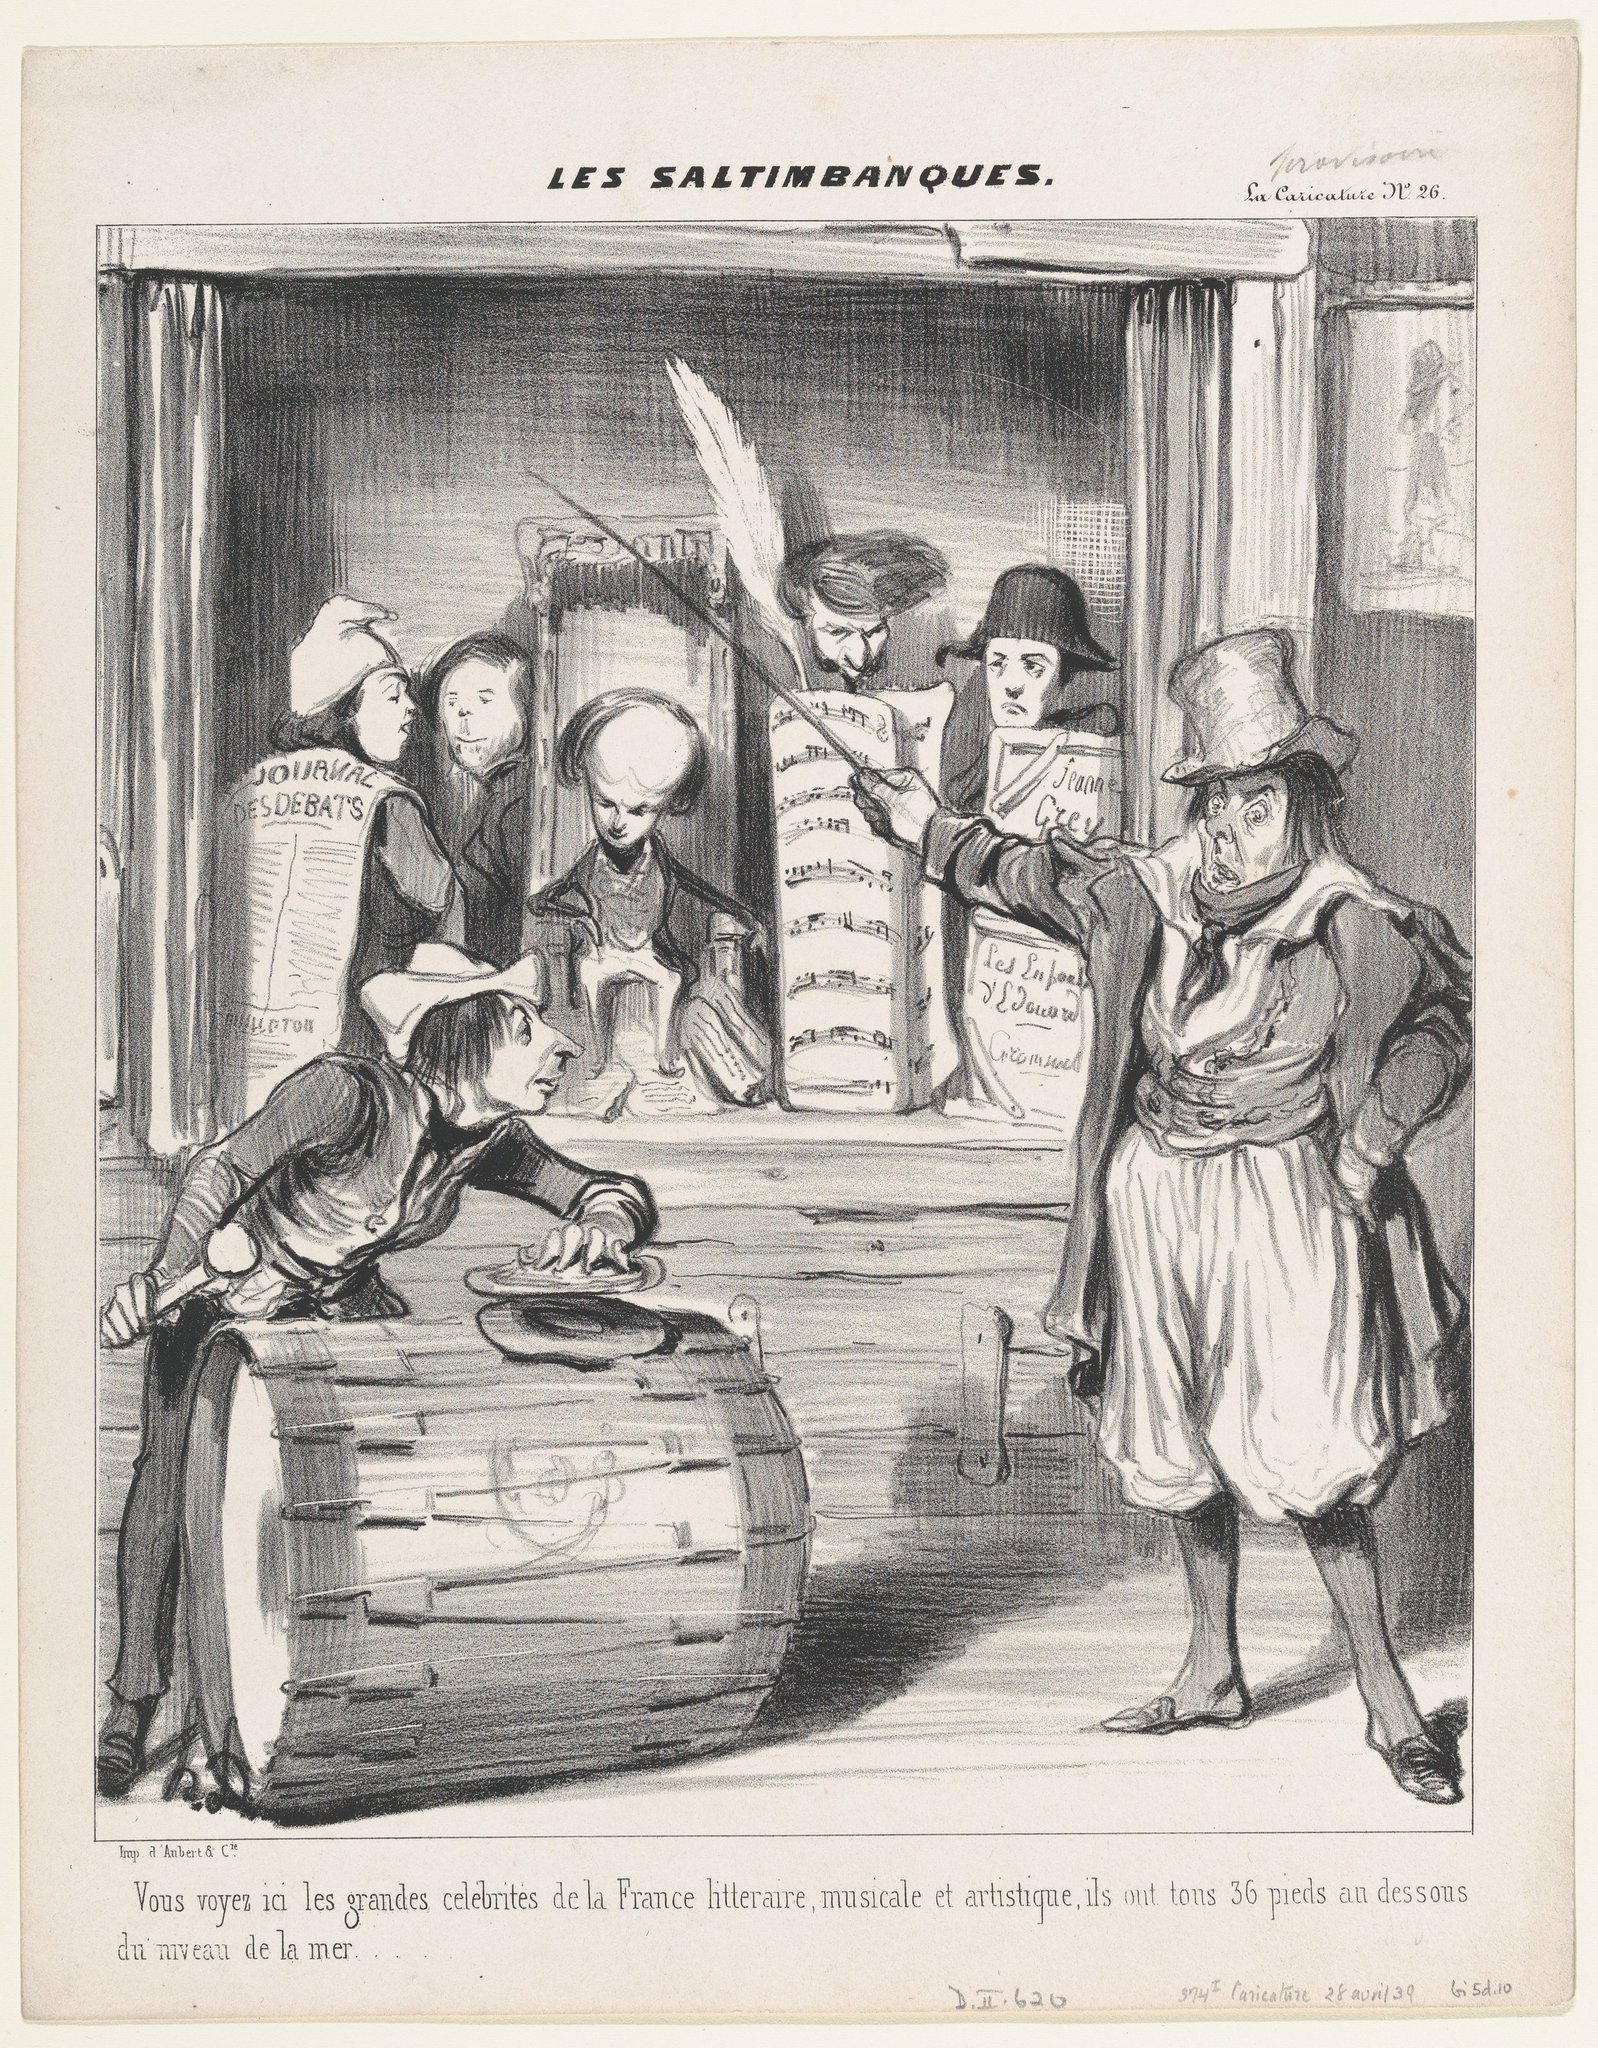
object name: print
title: Here you see the great celebrities of literary, musical, and artistic France; they are thirty-six feet tall measured below sea level (Vous voyez ici les grandez célébrités), from Les Saltimbanques, published in La Caricature, April 28, 1839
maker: honoré daumier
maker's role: artist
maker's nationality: french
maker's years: 1808-1879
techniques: lithograph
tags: musical instruments,men